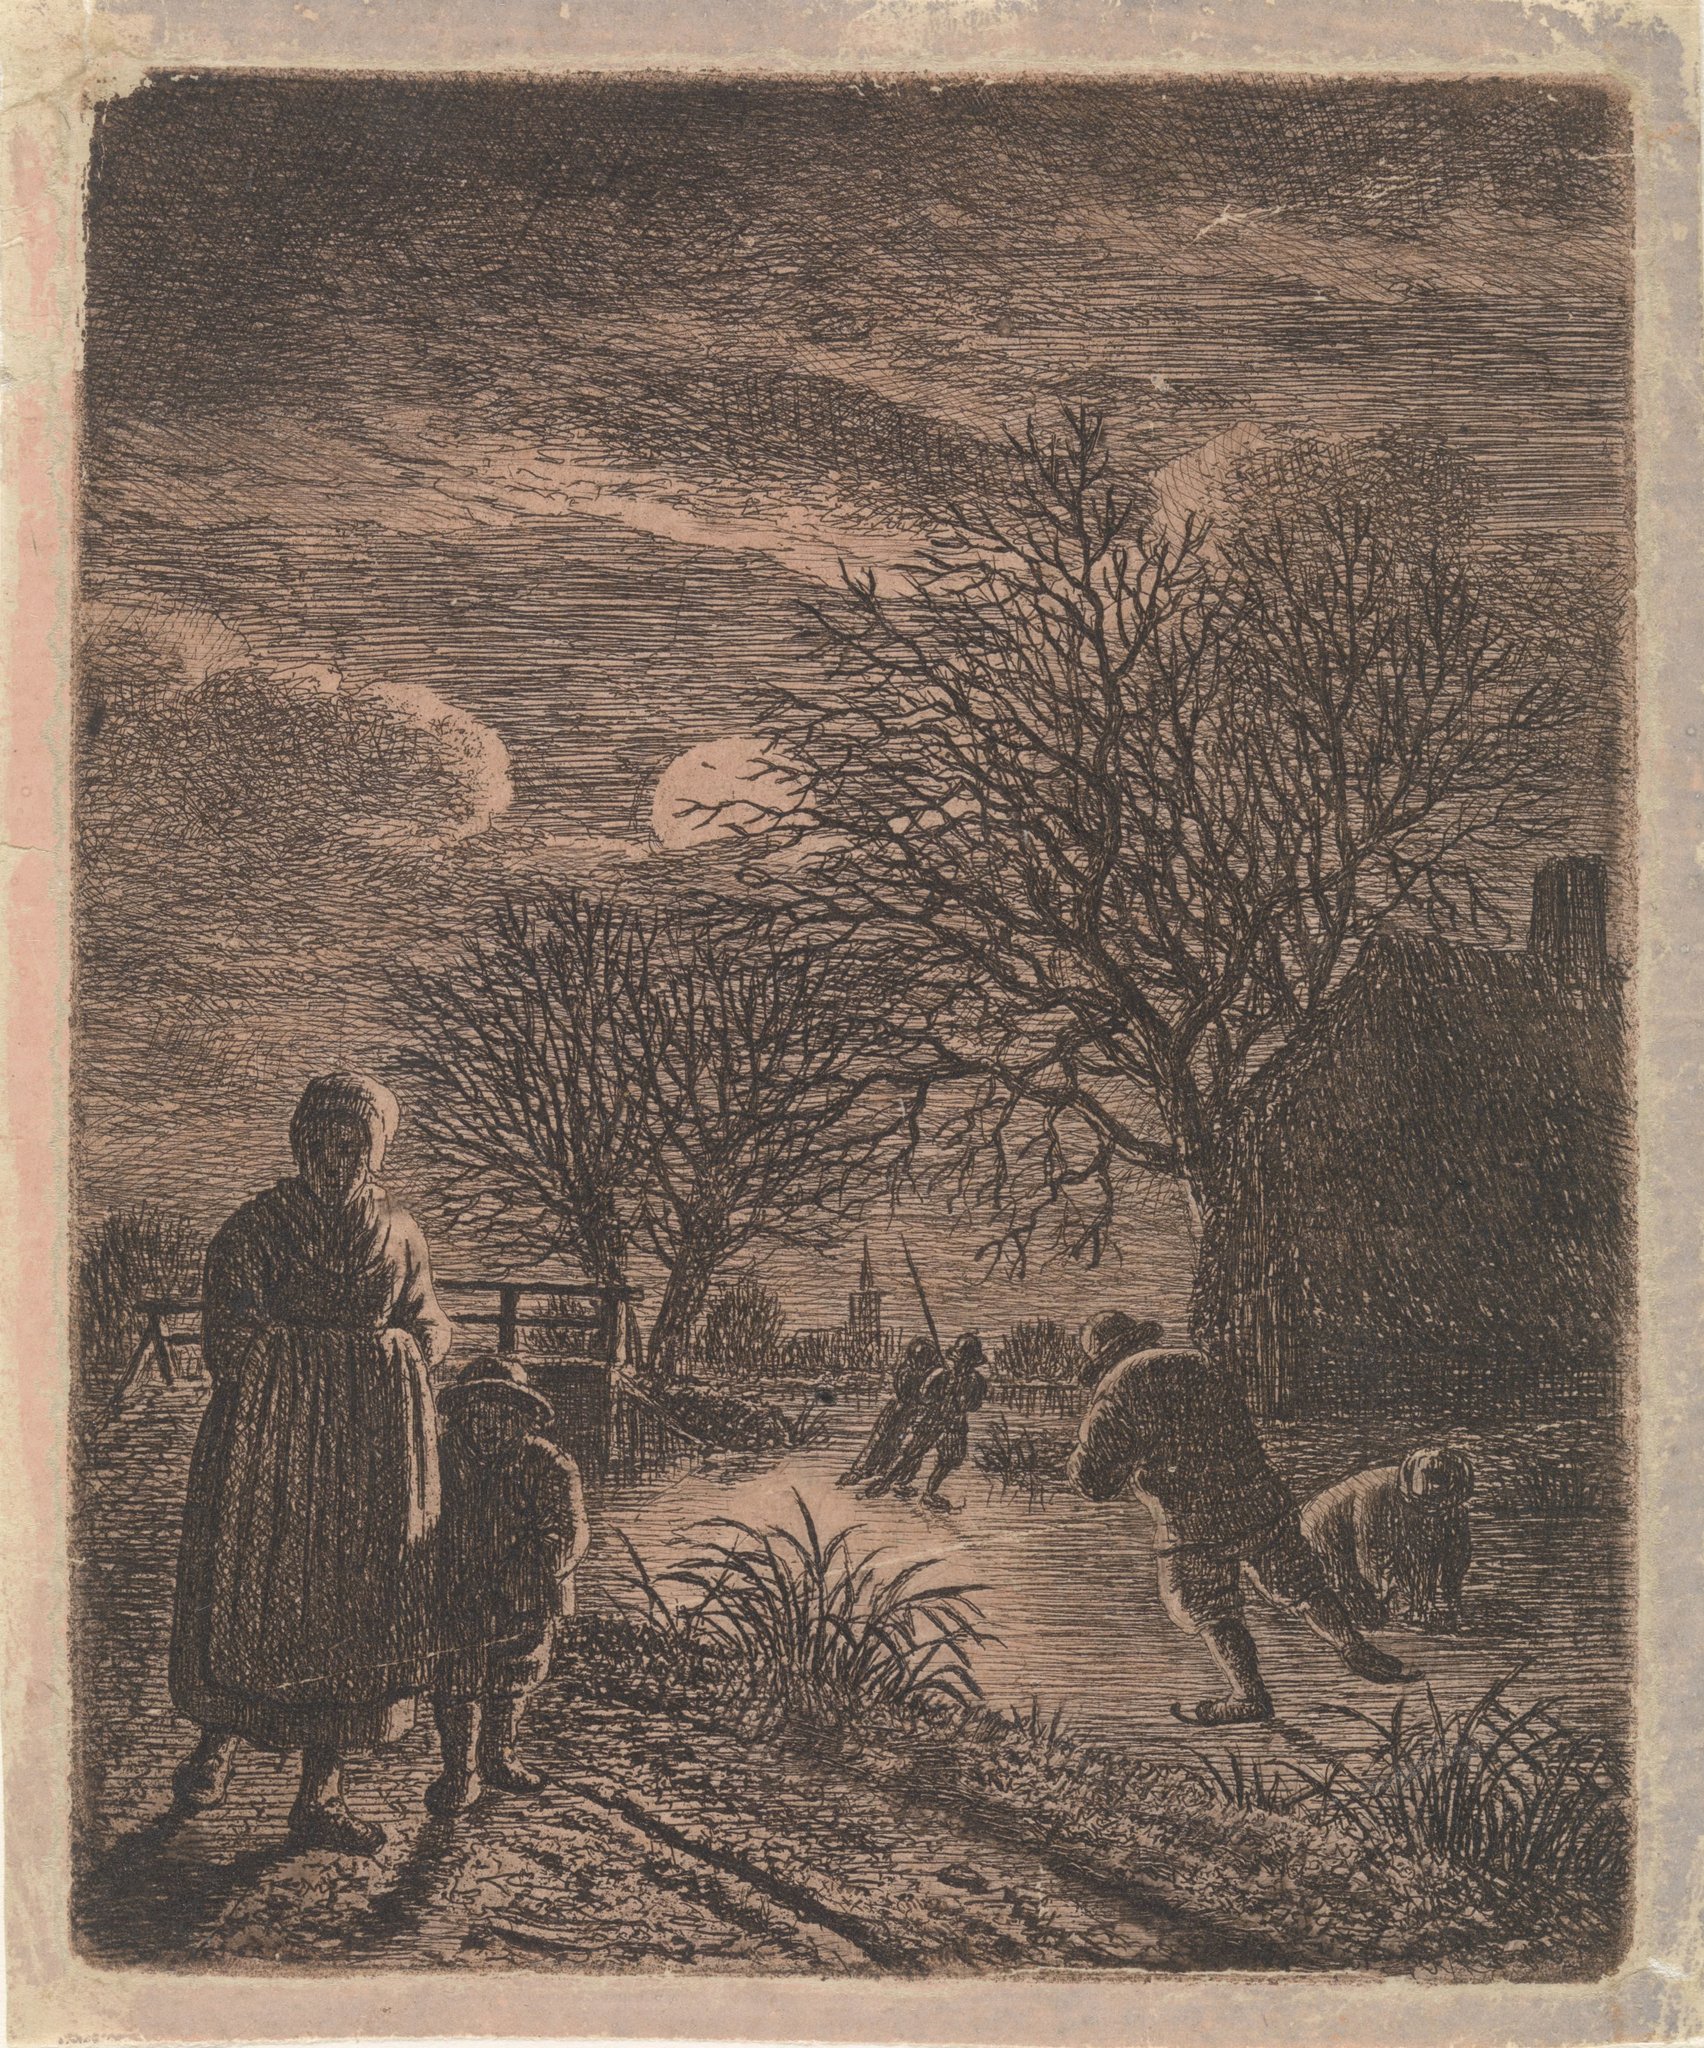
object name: print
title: Landschap met schaatsers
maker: johannes christiaan janson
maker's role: draughtsman, painter, print maker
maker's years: 1763-1823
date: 1778-1823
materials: paper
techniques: etching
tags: full moon, skates (winter sports)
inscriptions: collector's mark: Lugt 2228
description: Winterlandschap bij nacht met op de voorgrond een schaatser, op de rug gezien, en een gehurkte schaatser. Links een pad met een vrouw en een jongen. Op de achtergrond een kerk. Mét de lucht met maan.